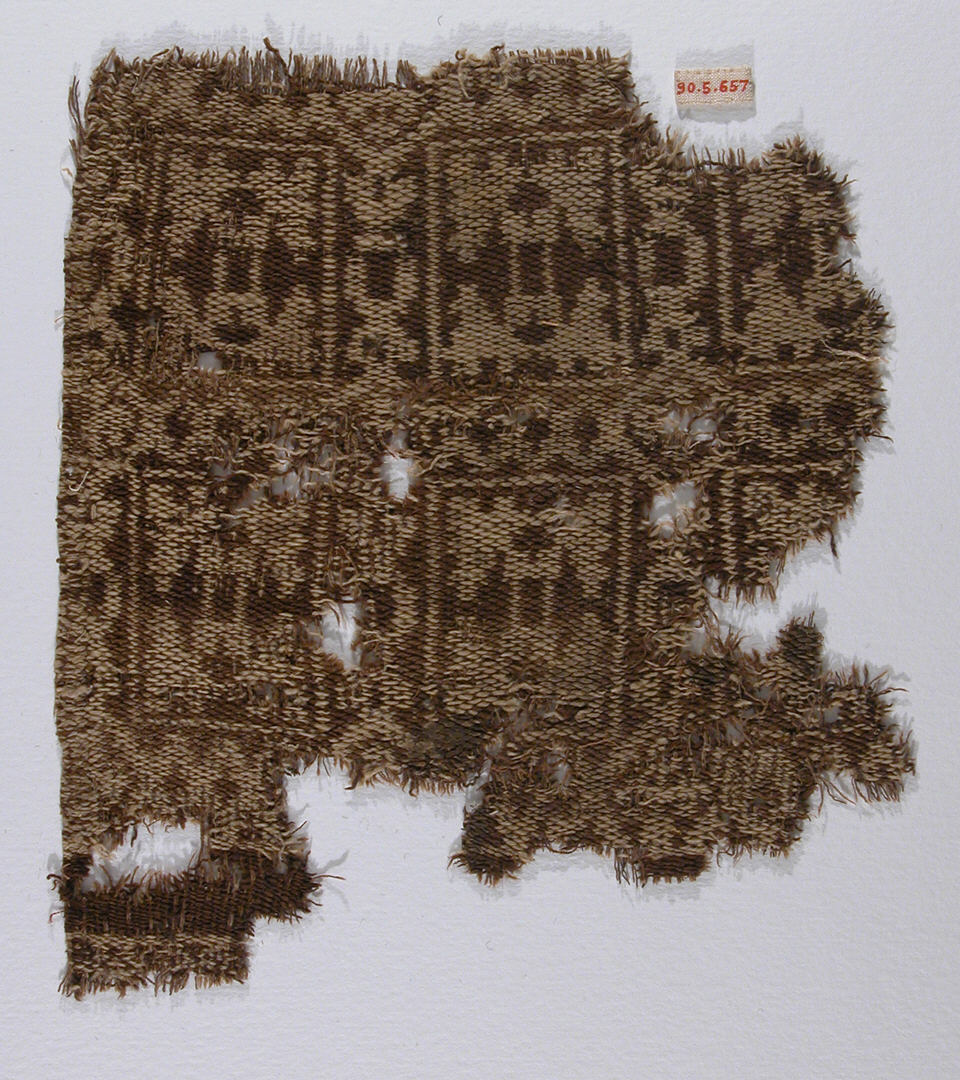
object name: textile fragment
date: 301-500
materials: wool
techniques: weave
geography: egypt